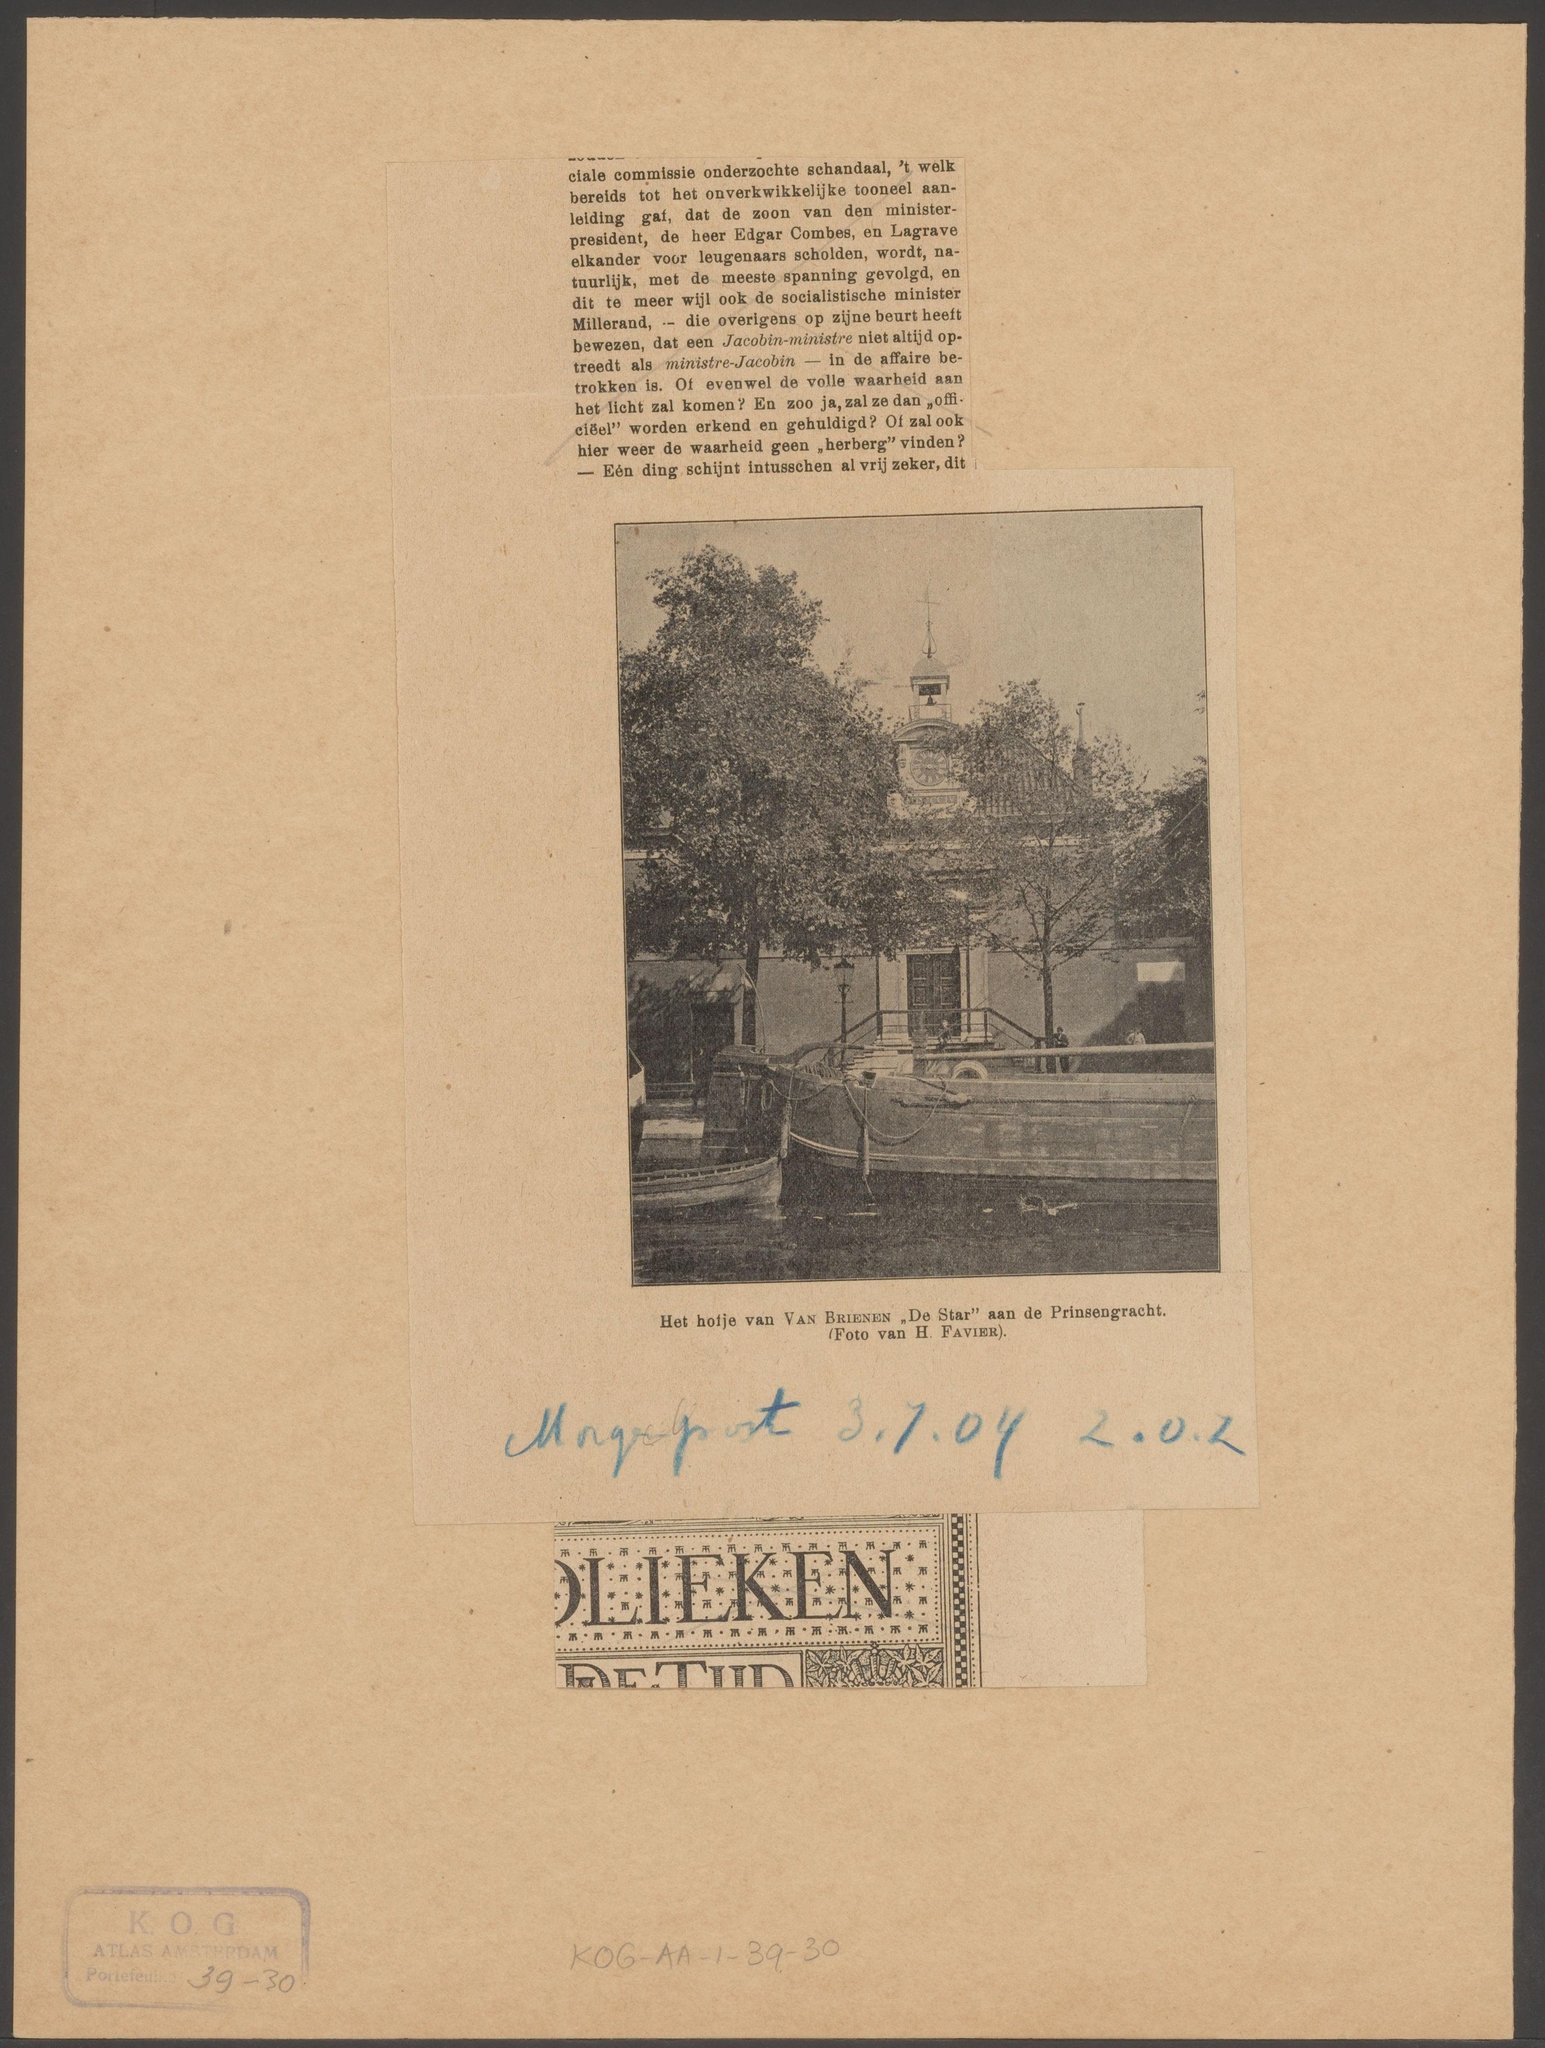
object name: photomechanical print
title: Gezicht op het Van Brienenhofje te Amsterdam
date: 1904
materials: paper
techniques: letterpress printing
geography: amsterdam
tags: alms-house (dutch: 'hofje'), canals, waters (in city) (+ city(-scape) with figures, staffage)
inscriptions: collector's mark: Lugt 1641b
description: Object bestaat uit twee aan elkaar geplakte bladen. Onderwerpsrubriek binnen de Atlas Amsterdam: Armwezen en liefdadige instellingen: III. Verschillende gestichten en instellingen / Hofjes: Van Brienenhofje “de Star” - Bijbels Hofje - Claes Reyniershofje - Constantiahofje.